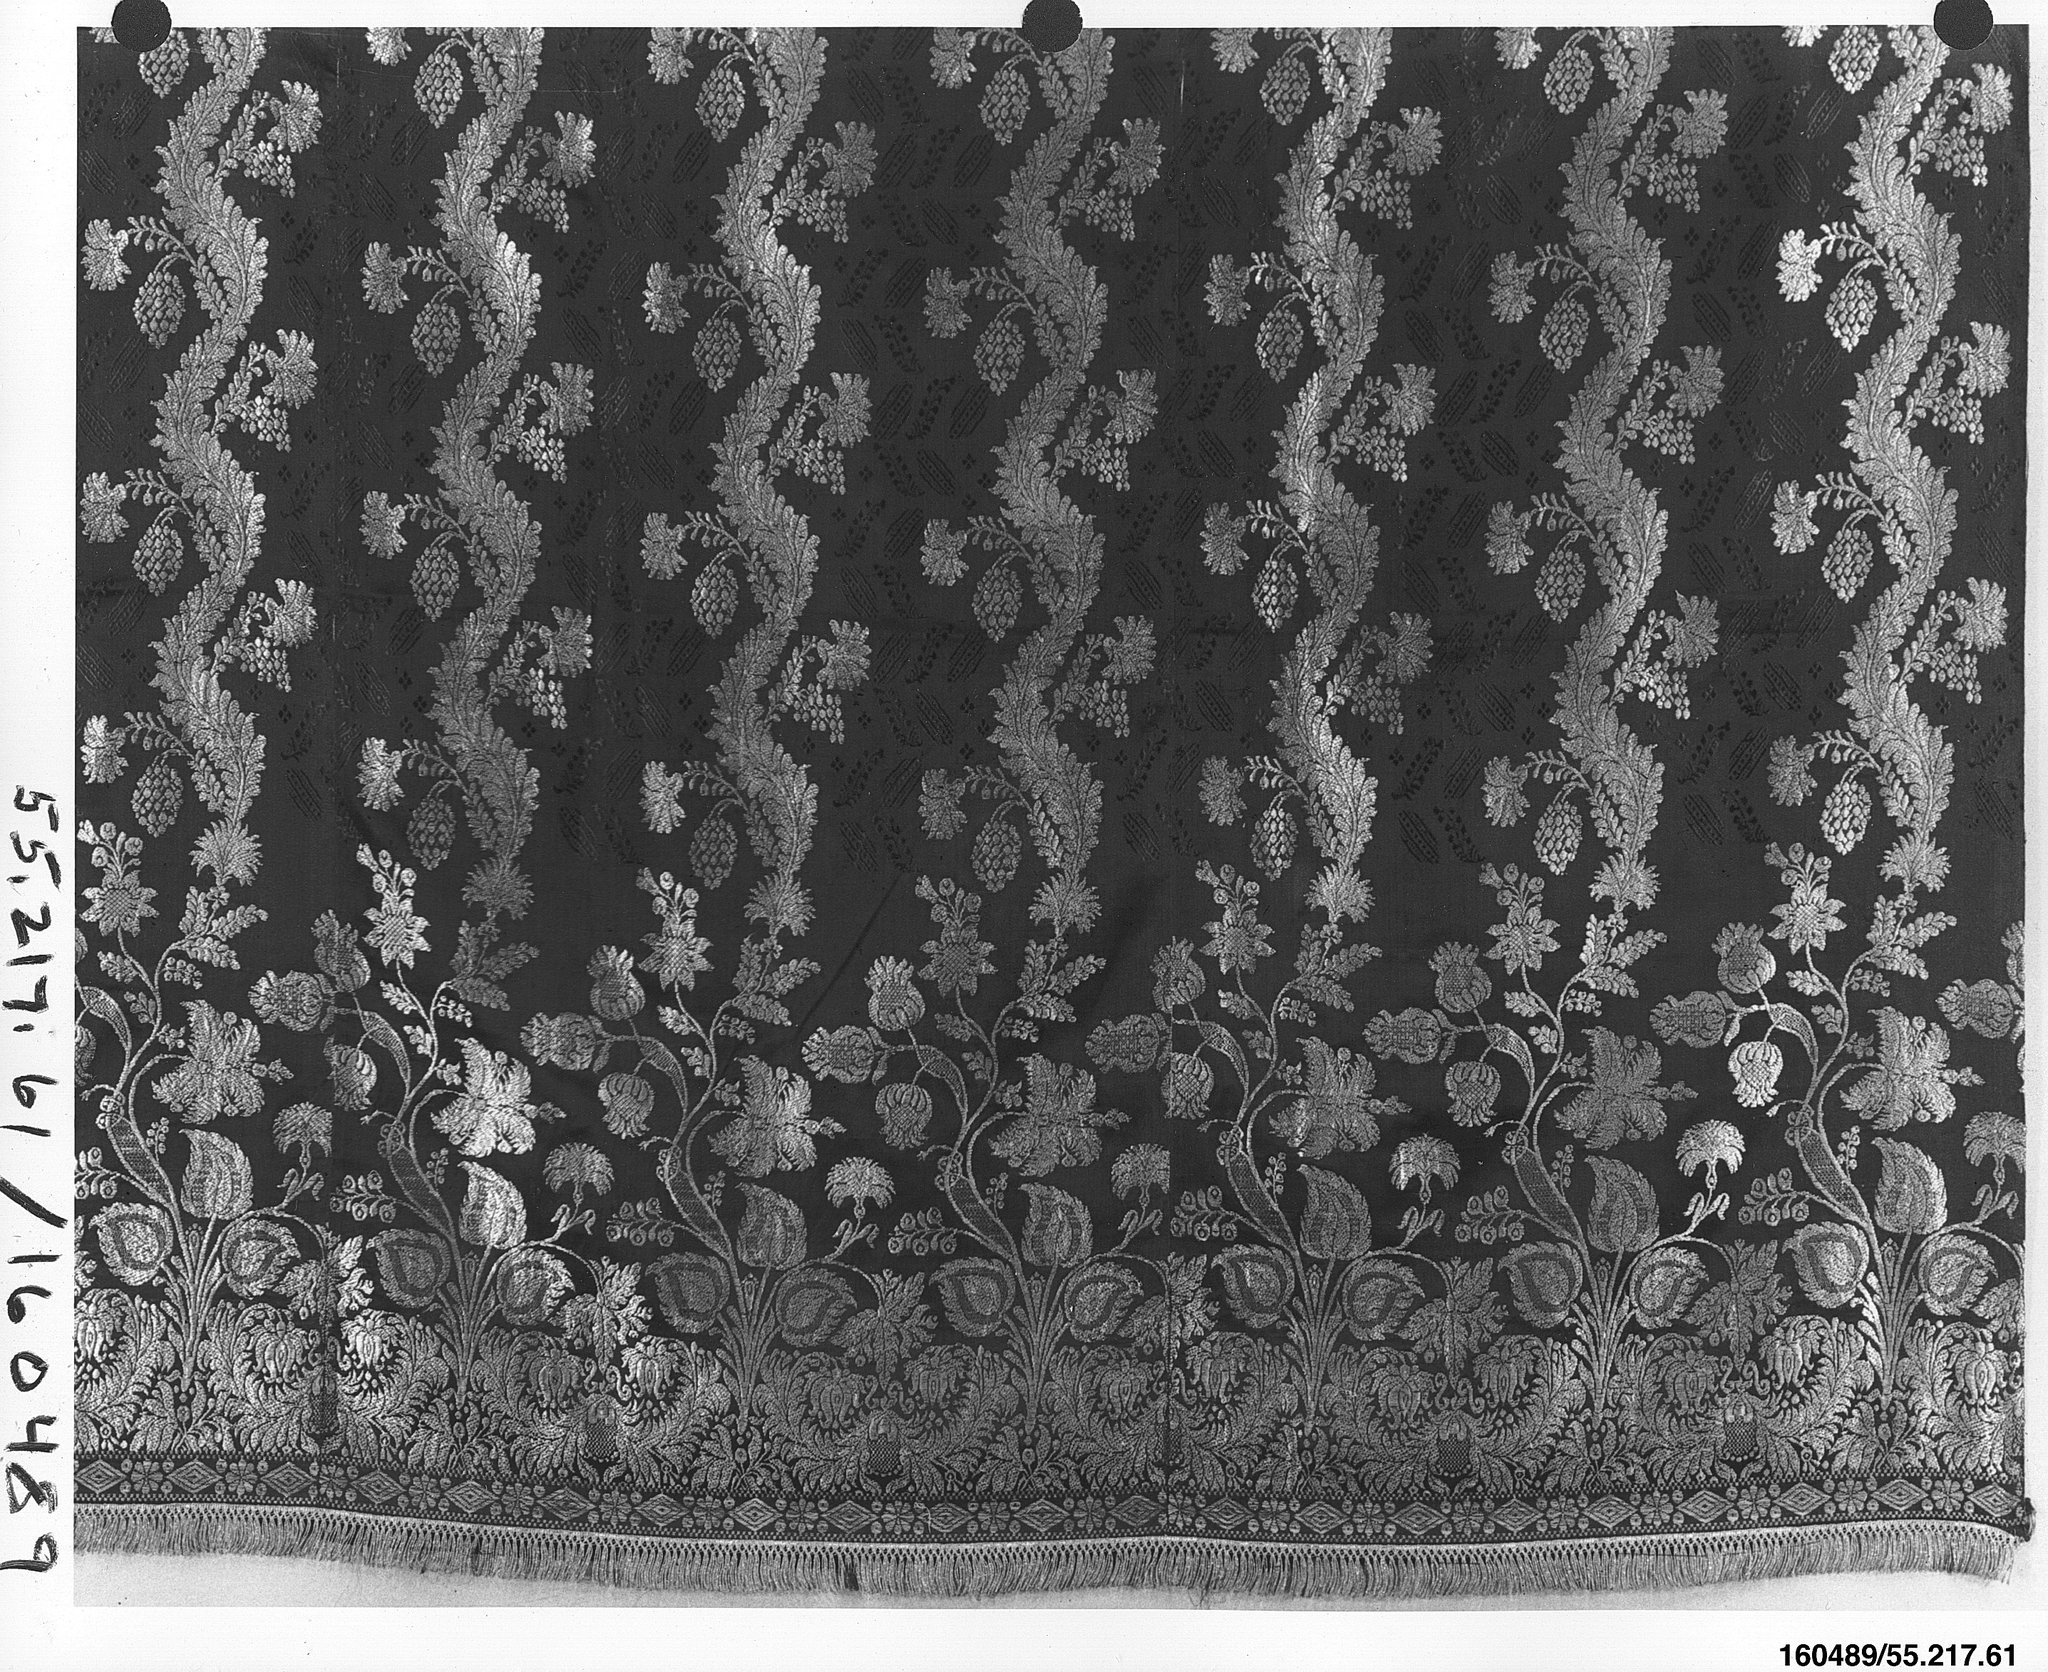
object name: piece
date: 1801-1900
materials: metal thread, silk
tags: flowers,leaves